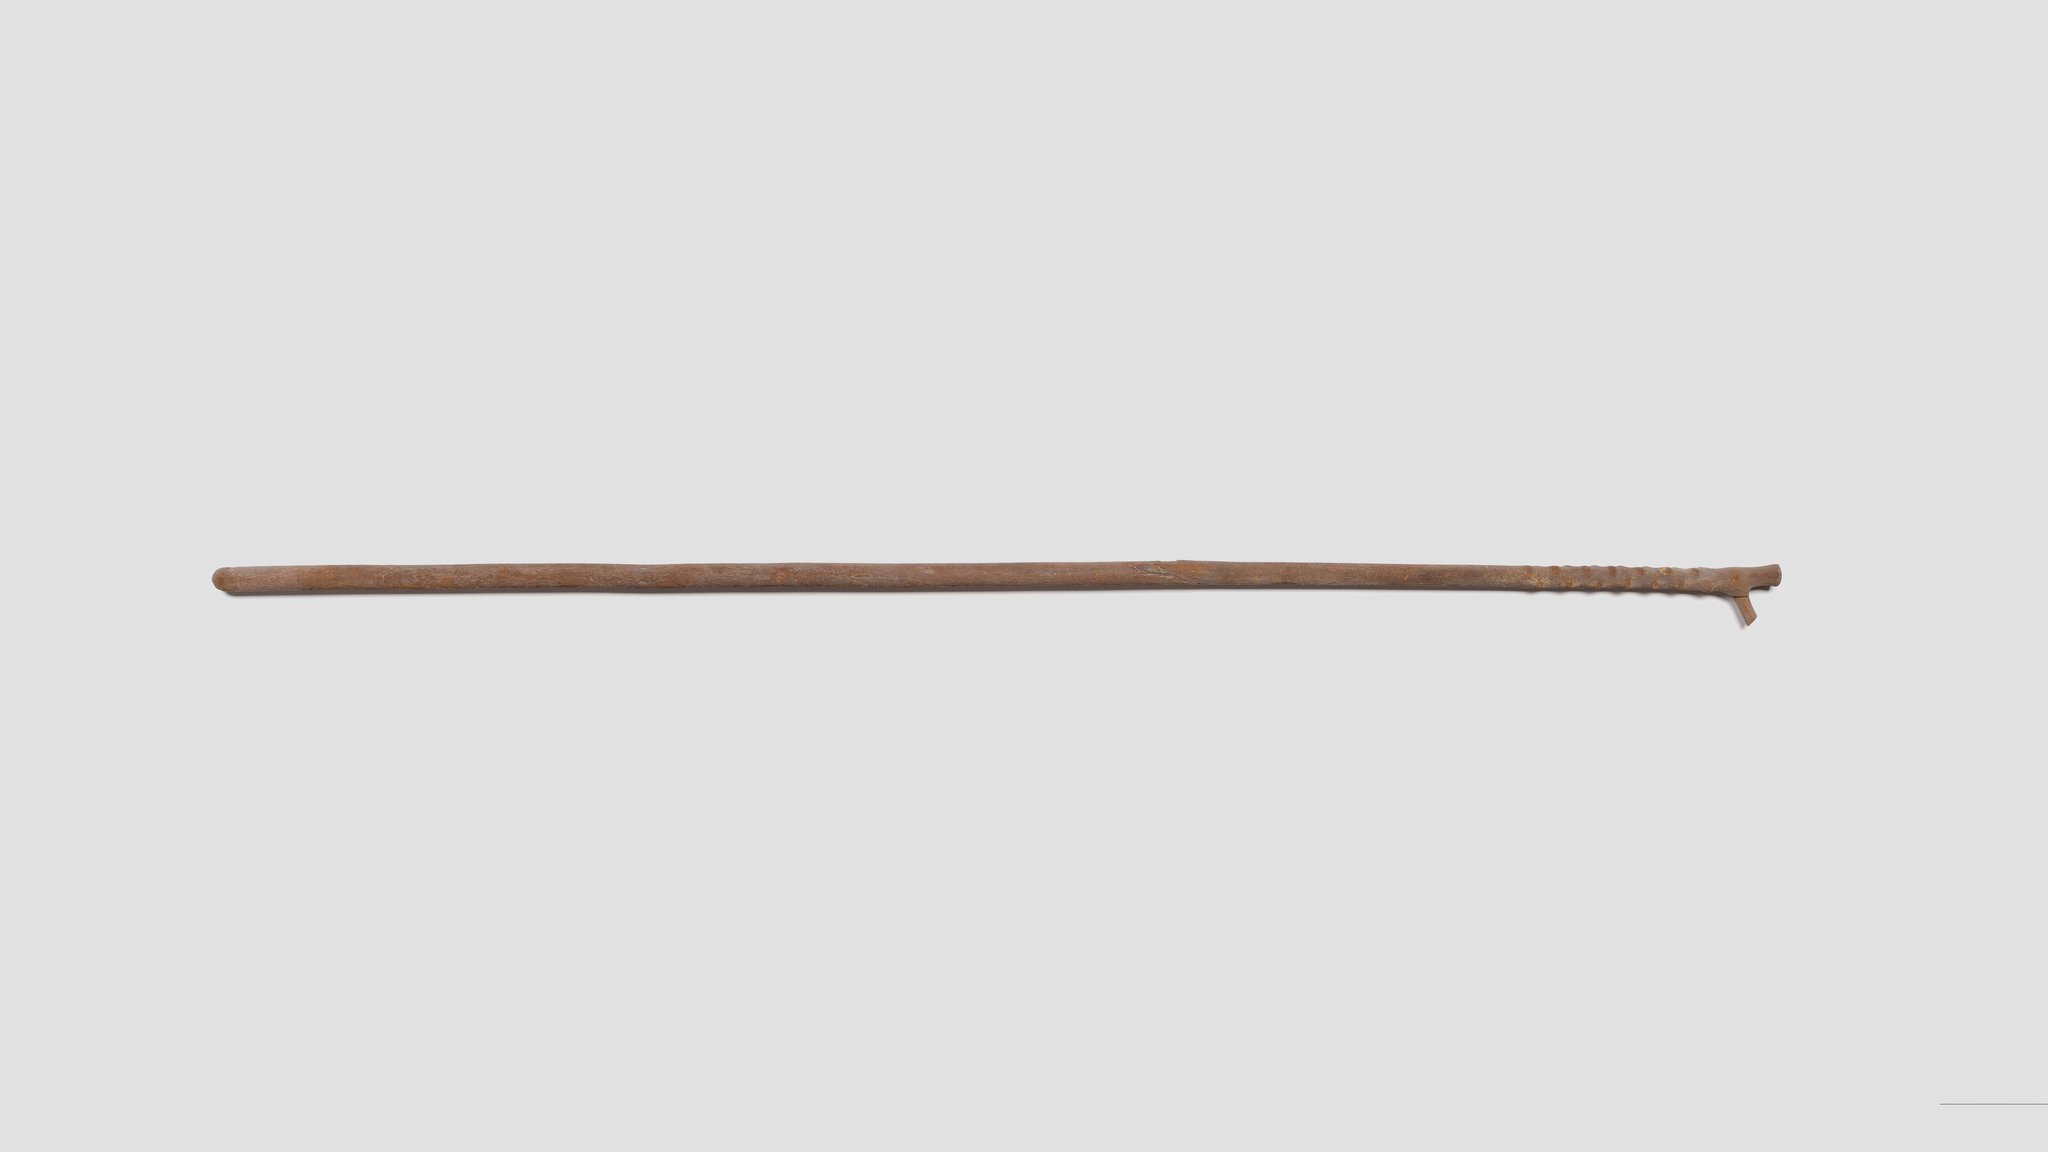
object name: staff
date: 1991-1450 BCE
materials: wood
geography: egypt